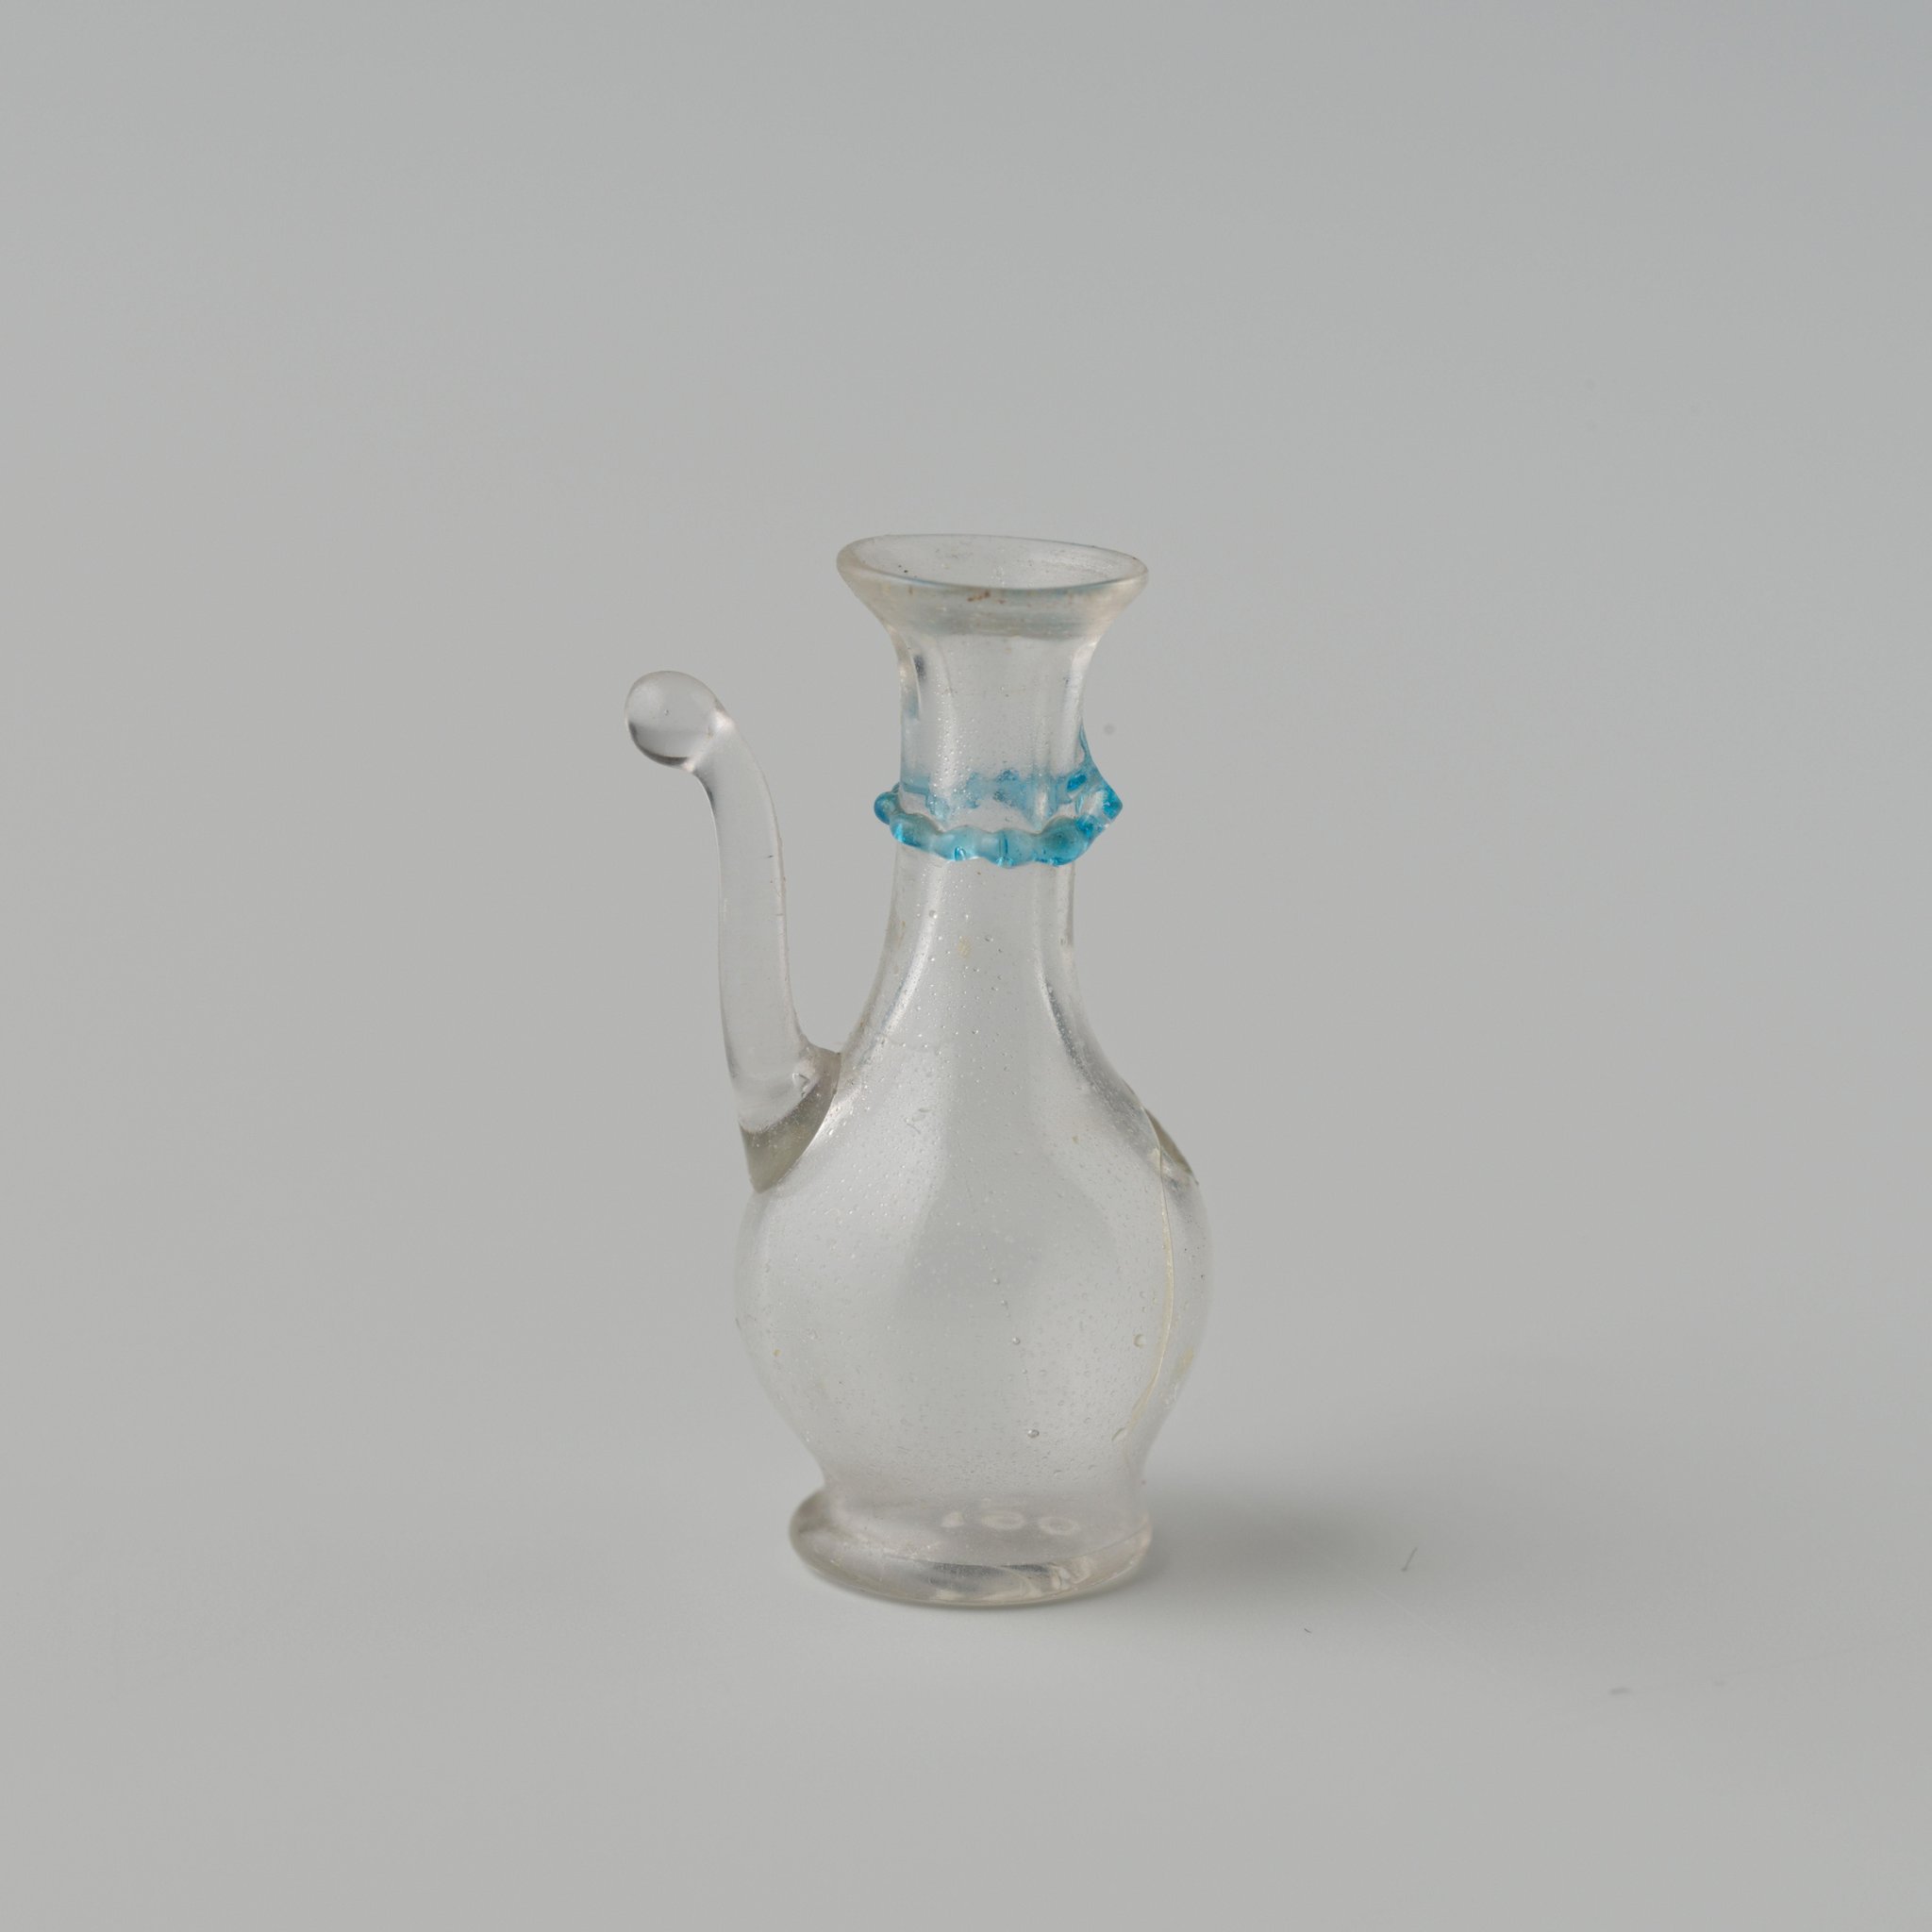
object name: ewer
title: Kan van helder kleurloos glas, glad slank model op vlakke iets naar buiten gebogen bodem; blauwe geknepen halsring, S-vormige massieve tuit en handvat.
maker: Anonymous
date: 1675-1710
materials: glass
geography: amsterdam